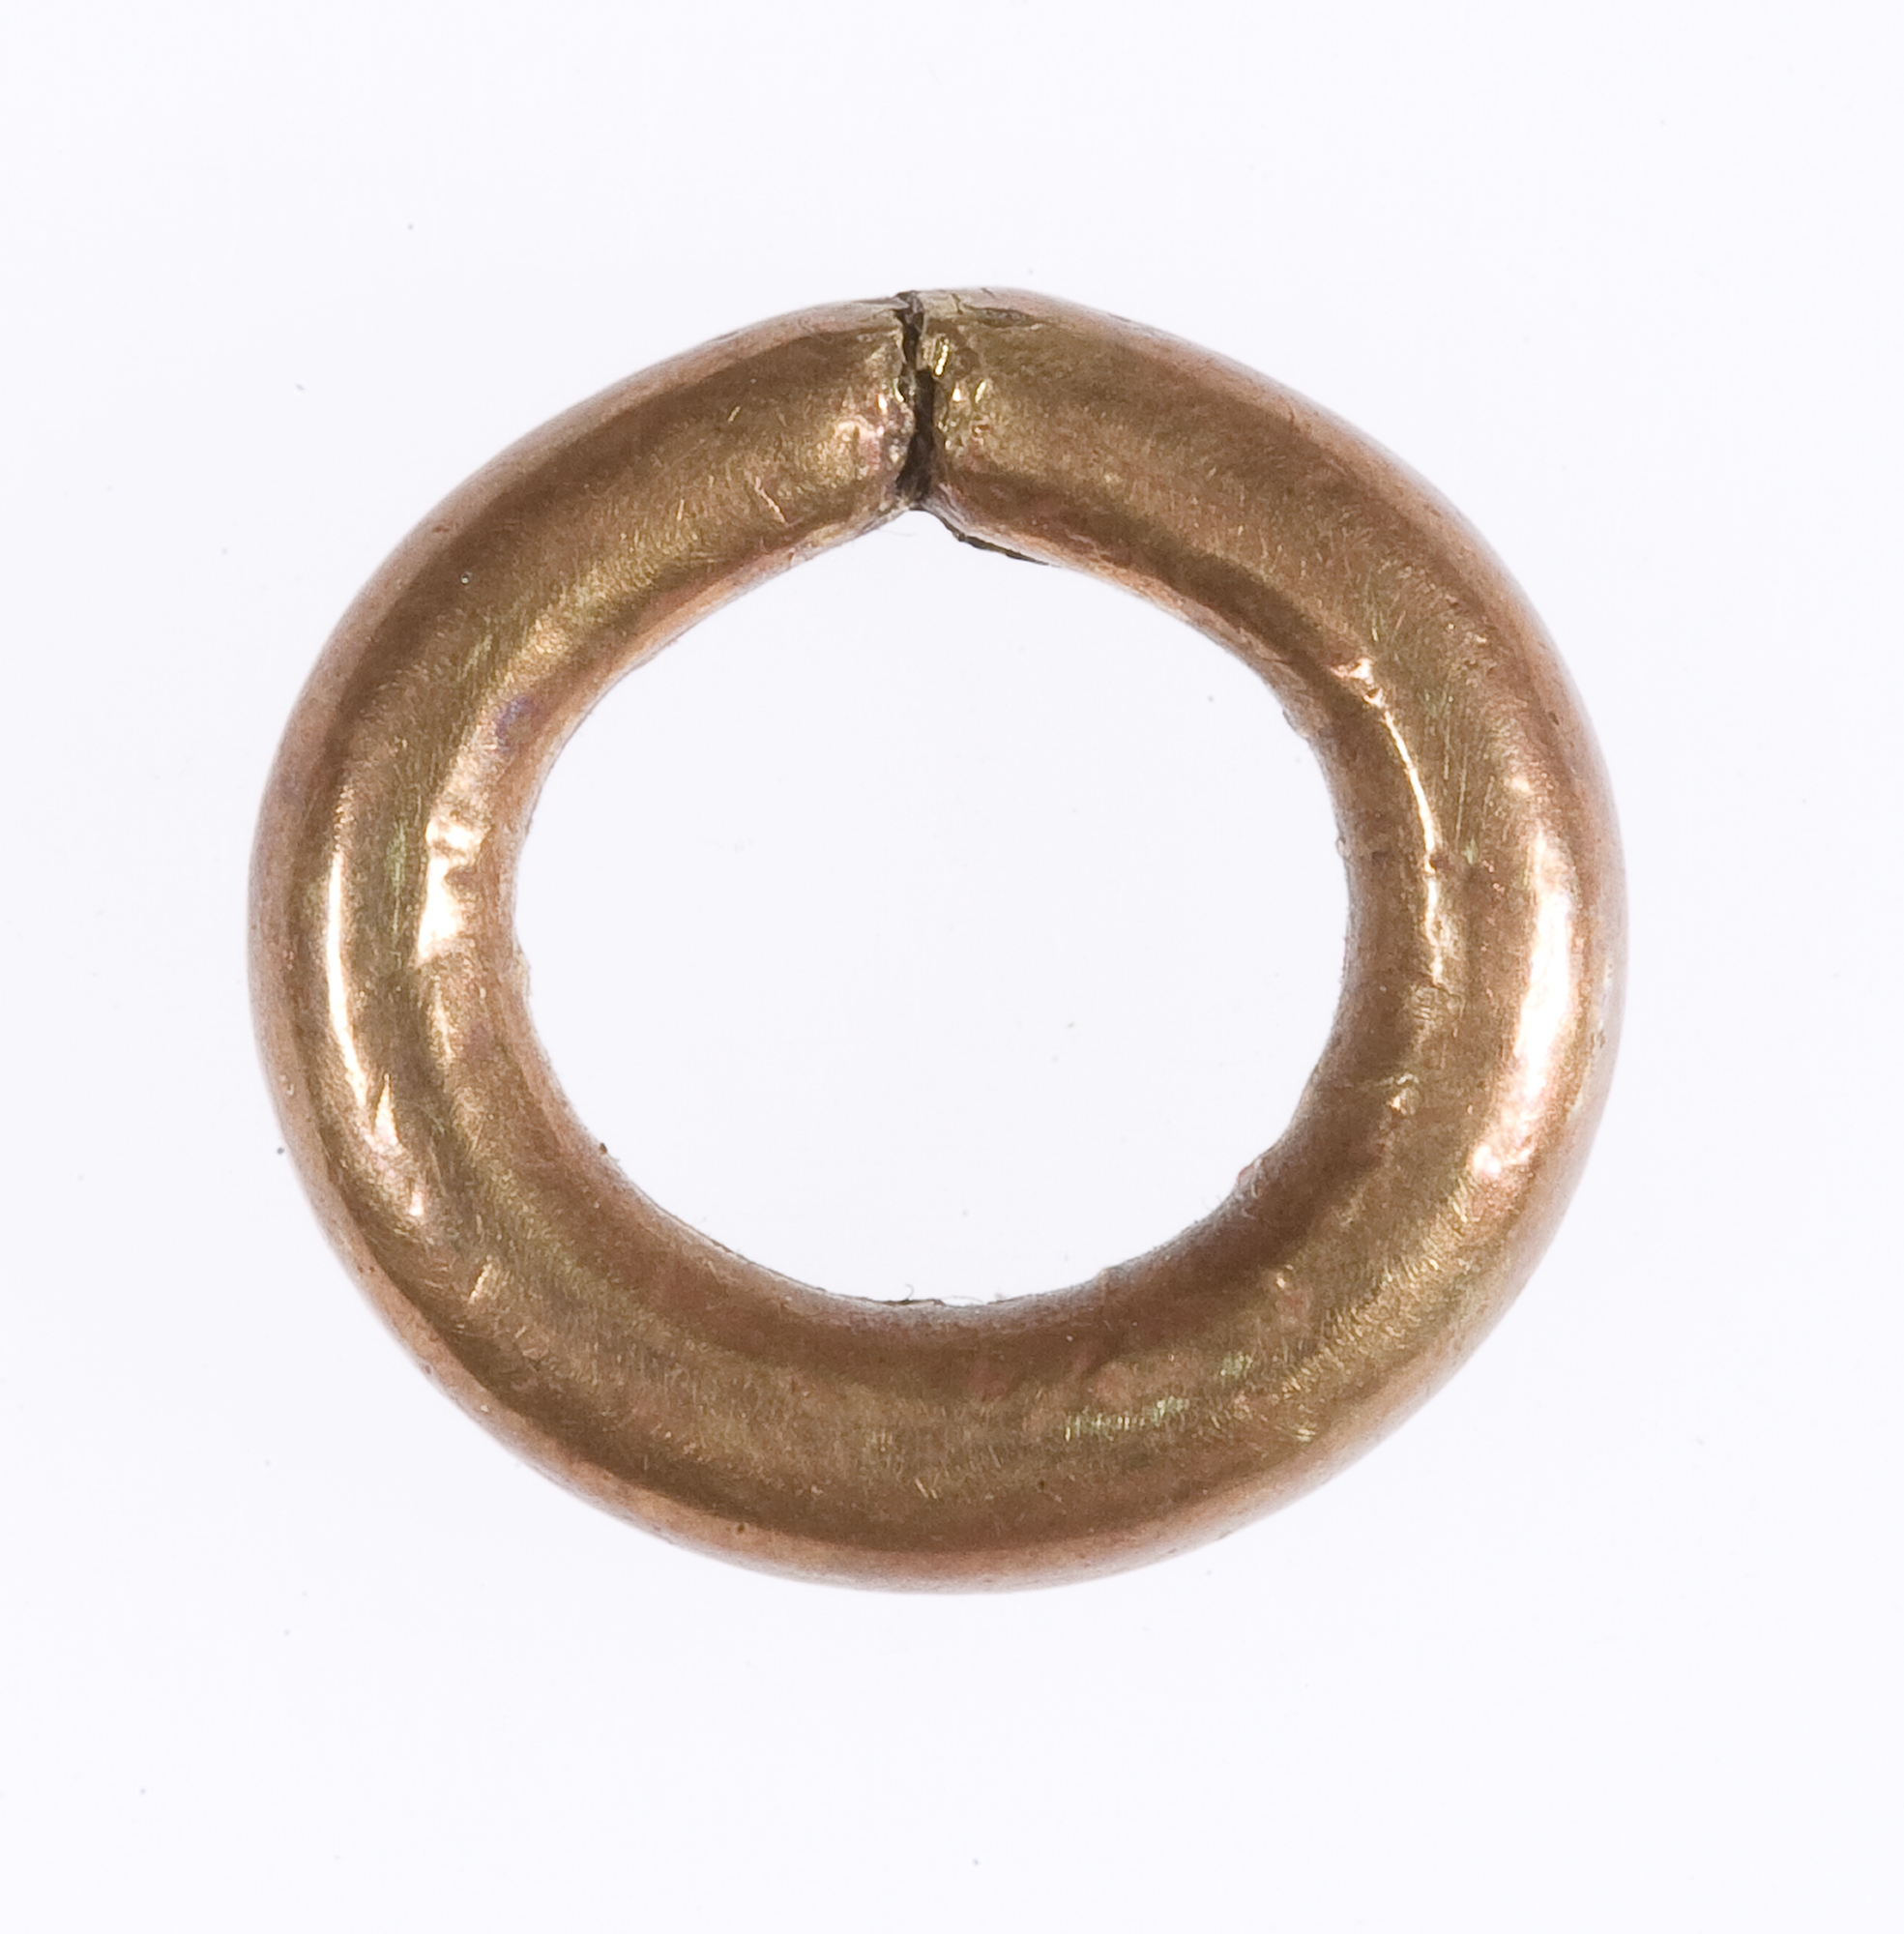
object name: earring, penannular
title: Penannular Earring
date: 1550-1425 BCE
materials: gold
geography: egypt